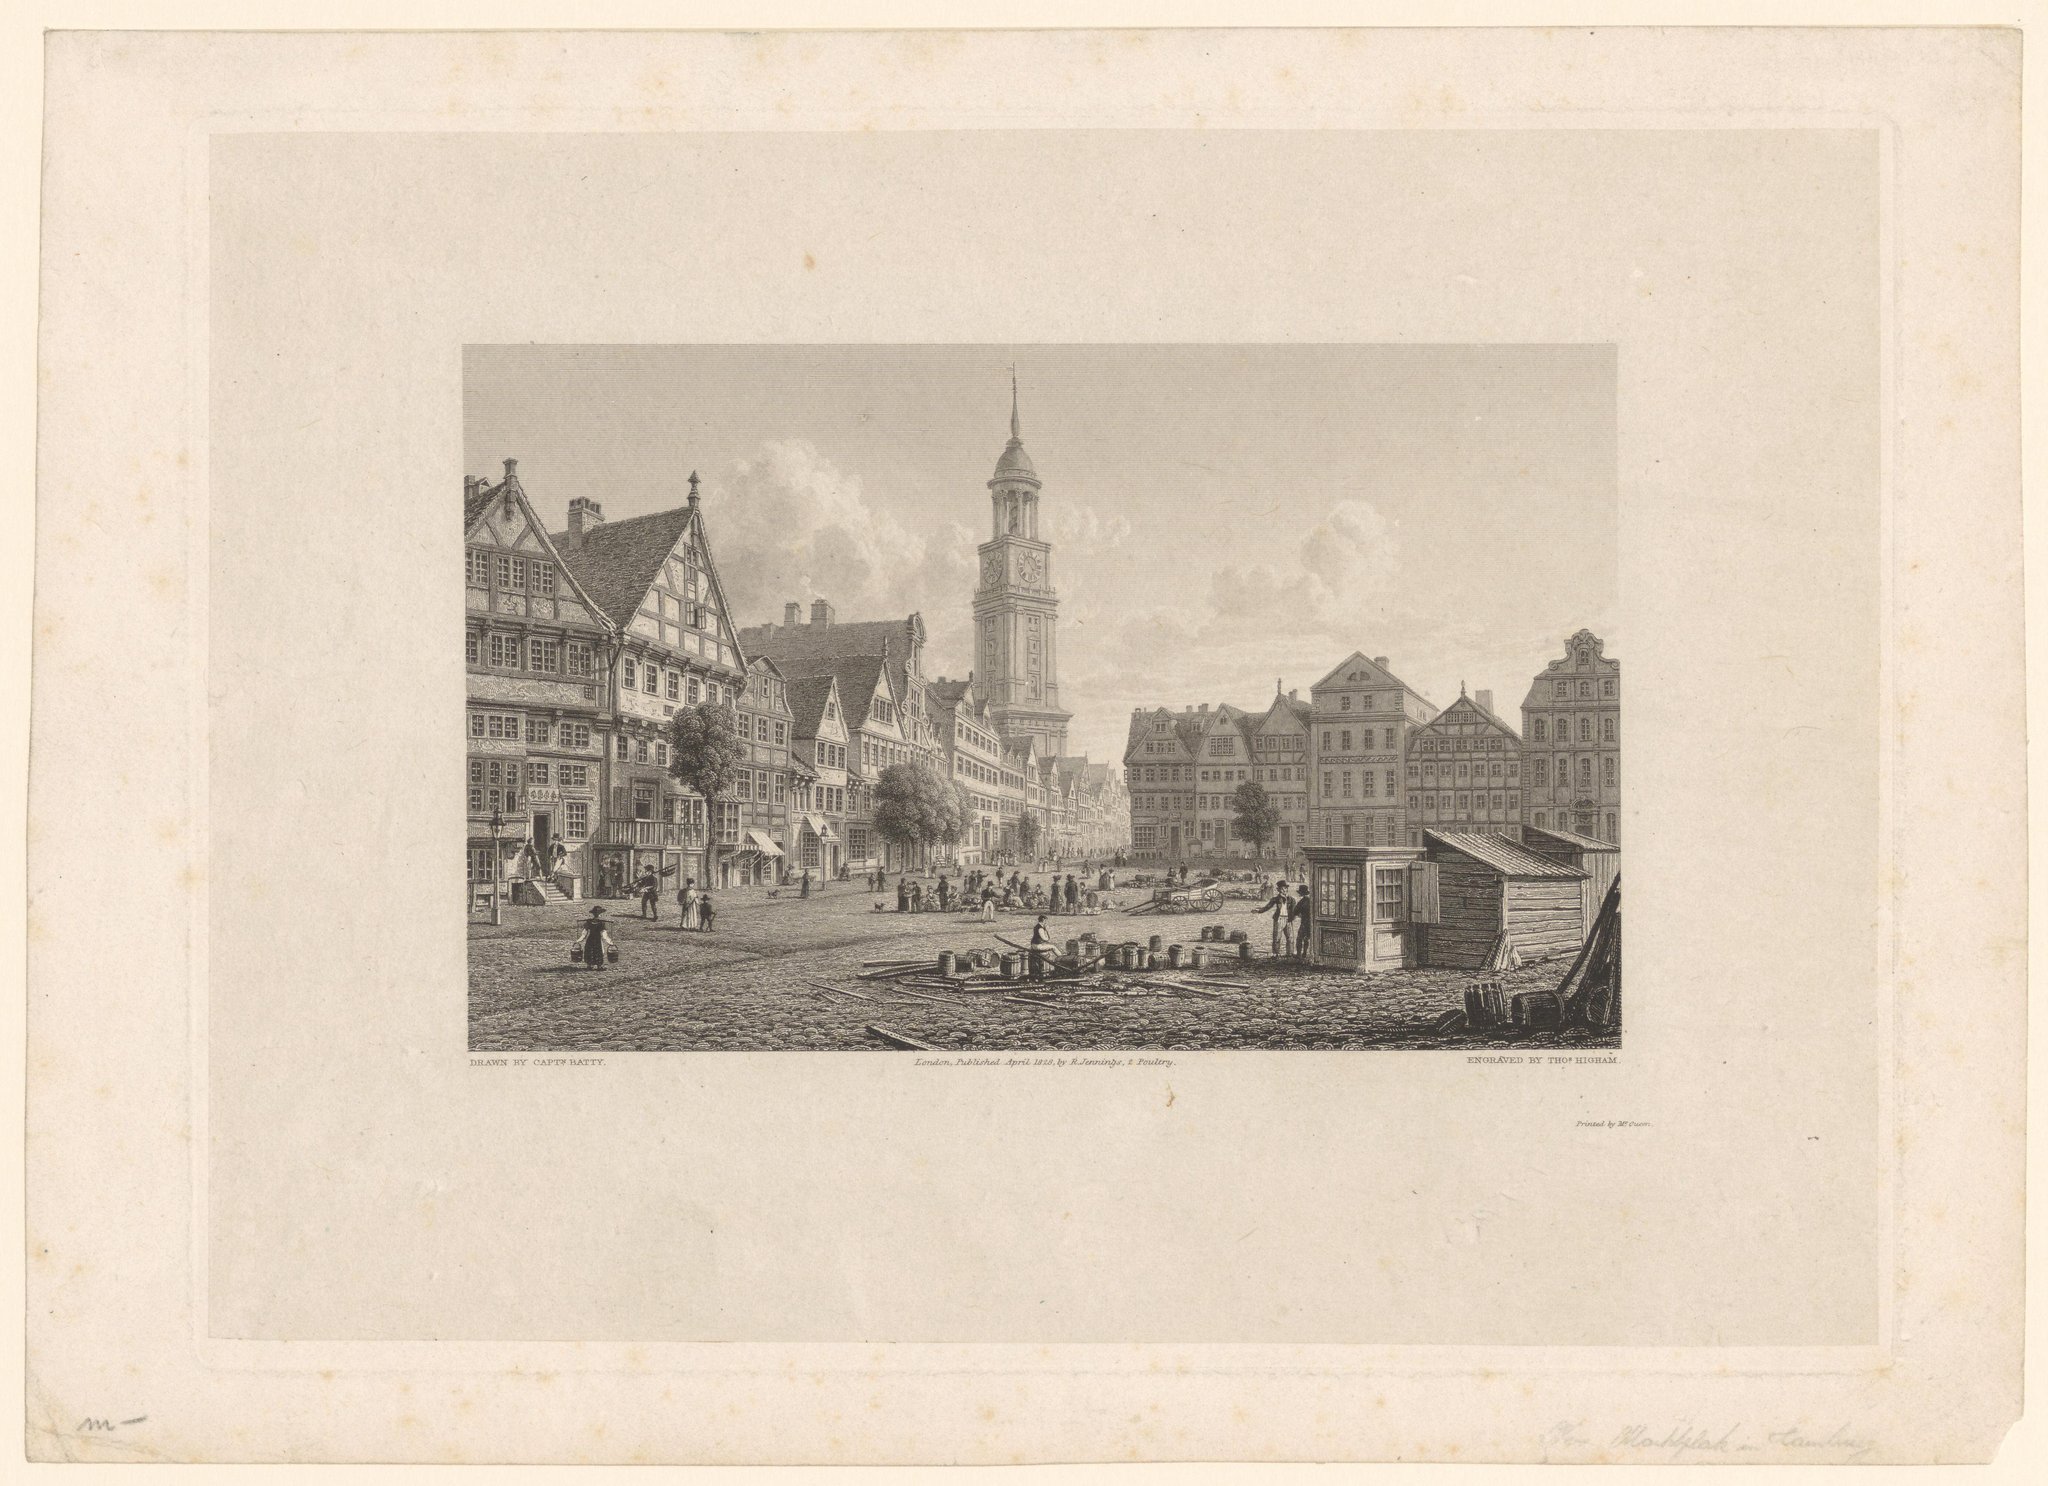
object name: print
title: Gezicht op de Grossneumarkt in Hamburg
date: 1804-1828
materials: paper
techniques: engraving, etching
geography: london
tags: square, place, circus, etc. (+ city(-scape) with figures, staffage), city-view in general; 'veduta' (+ city(-scape) with figures, staffage)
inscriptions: collector's mark: Lugt 2228